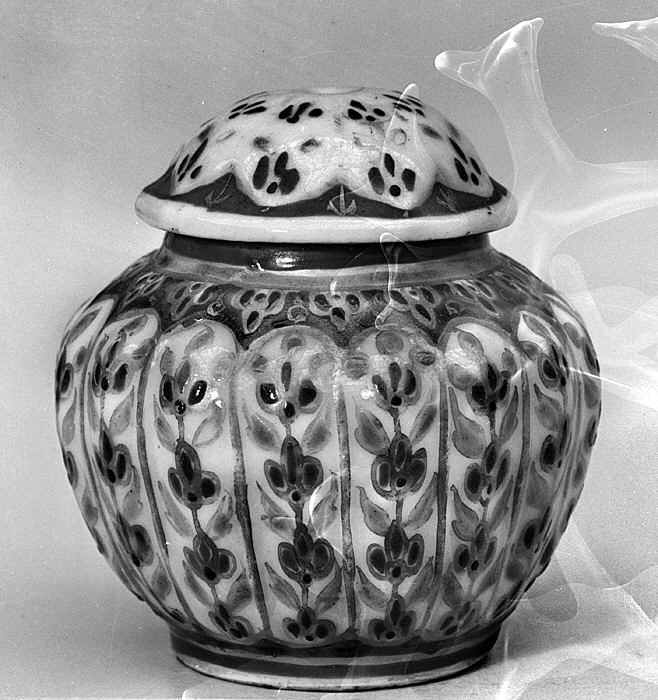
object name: covered jar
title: Covered jar with floral patterns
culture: chinese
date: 1801-1900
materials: enamel, porcelain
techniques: overglaze, painting, polychrome